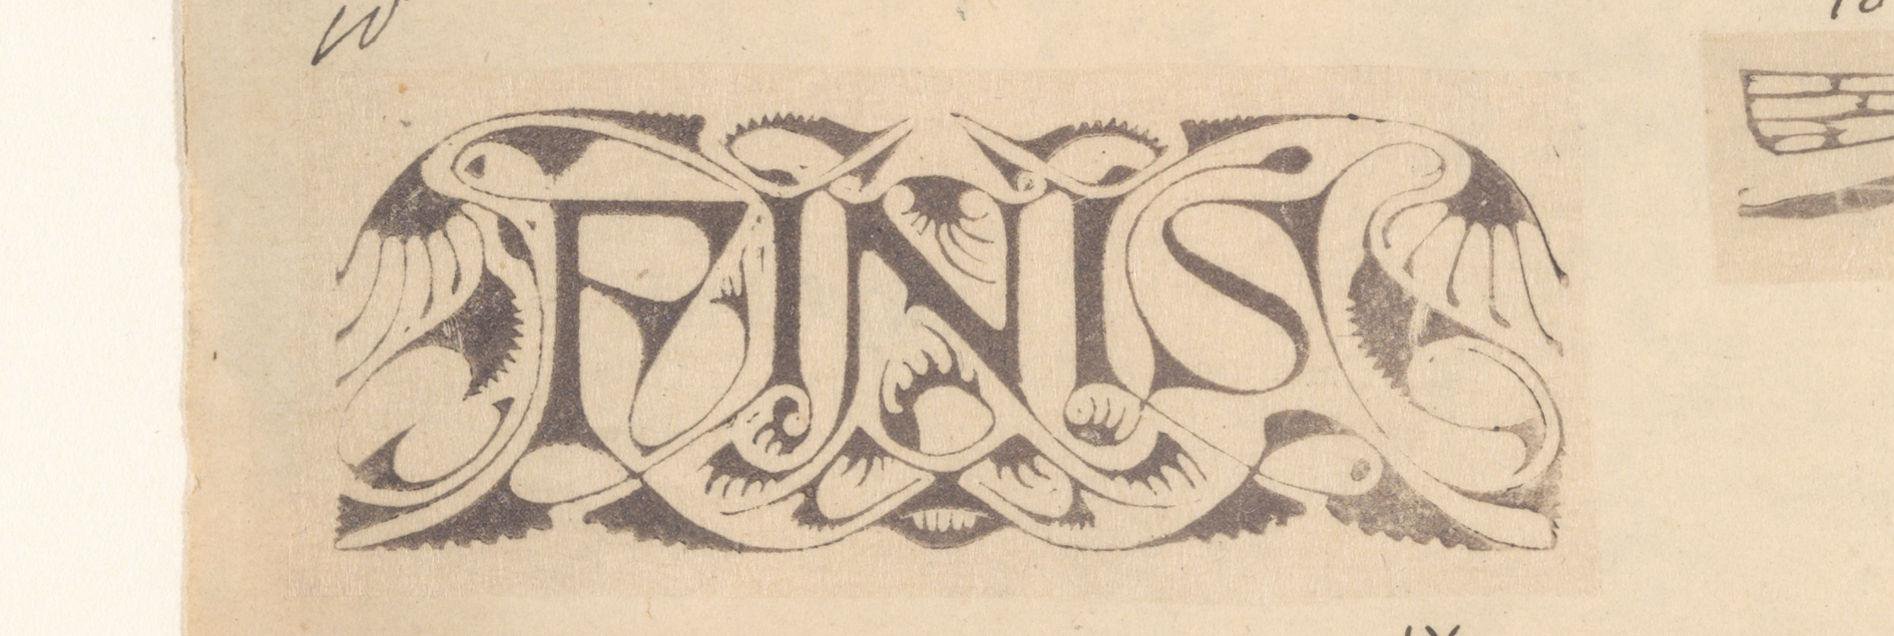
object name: vignette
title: Vignet FINIS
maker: karel petrus cornelis de bazel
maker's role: draughtsman, print maker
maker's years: 1869-1923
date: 1896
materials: paper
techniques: woodcut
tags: end; 'fine' (ripa), vignette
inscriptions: collector's mark: Lugt 2228